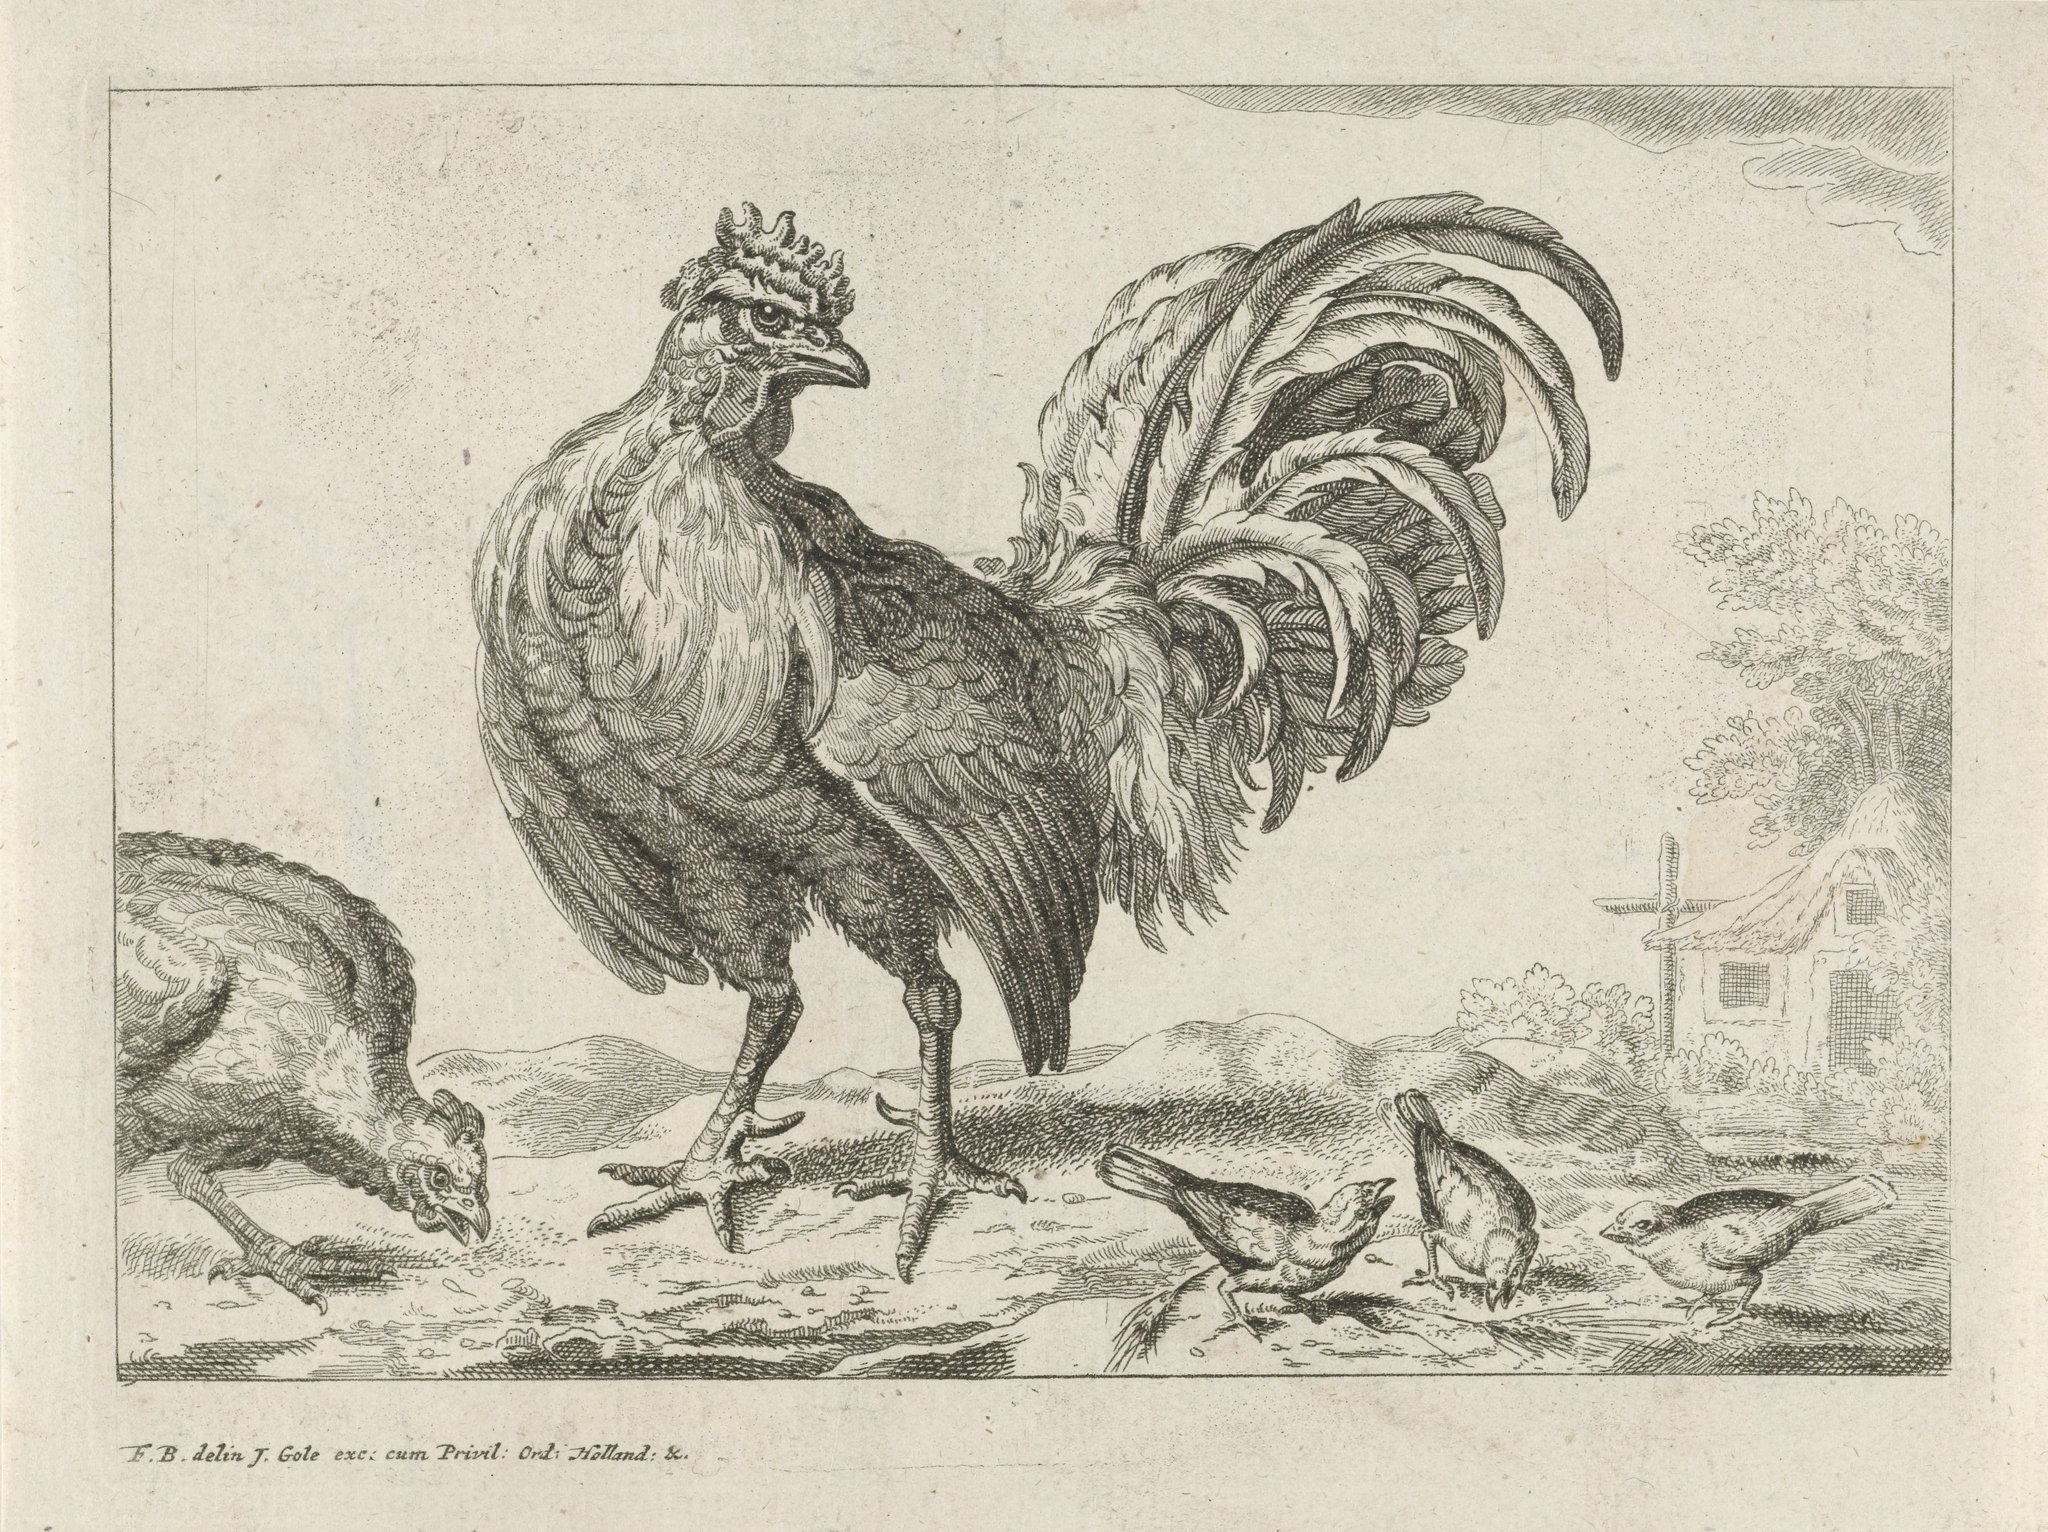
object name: print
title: Haan met kuikens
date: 1680-1723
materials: paper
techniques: etching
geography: amsterdam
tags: fowl (cock, hen, chicken, etc.), farm (building)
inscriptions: collector's mark: Lugt 2228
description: Een haan met op de voorgrond enkele kuikens. Links een scharrelende kip. Op de achtergrond de boerderij. De prent maakt deel uit van een serie met verschillende dieren als onderwerp.